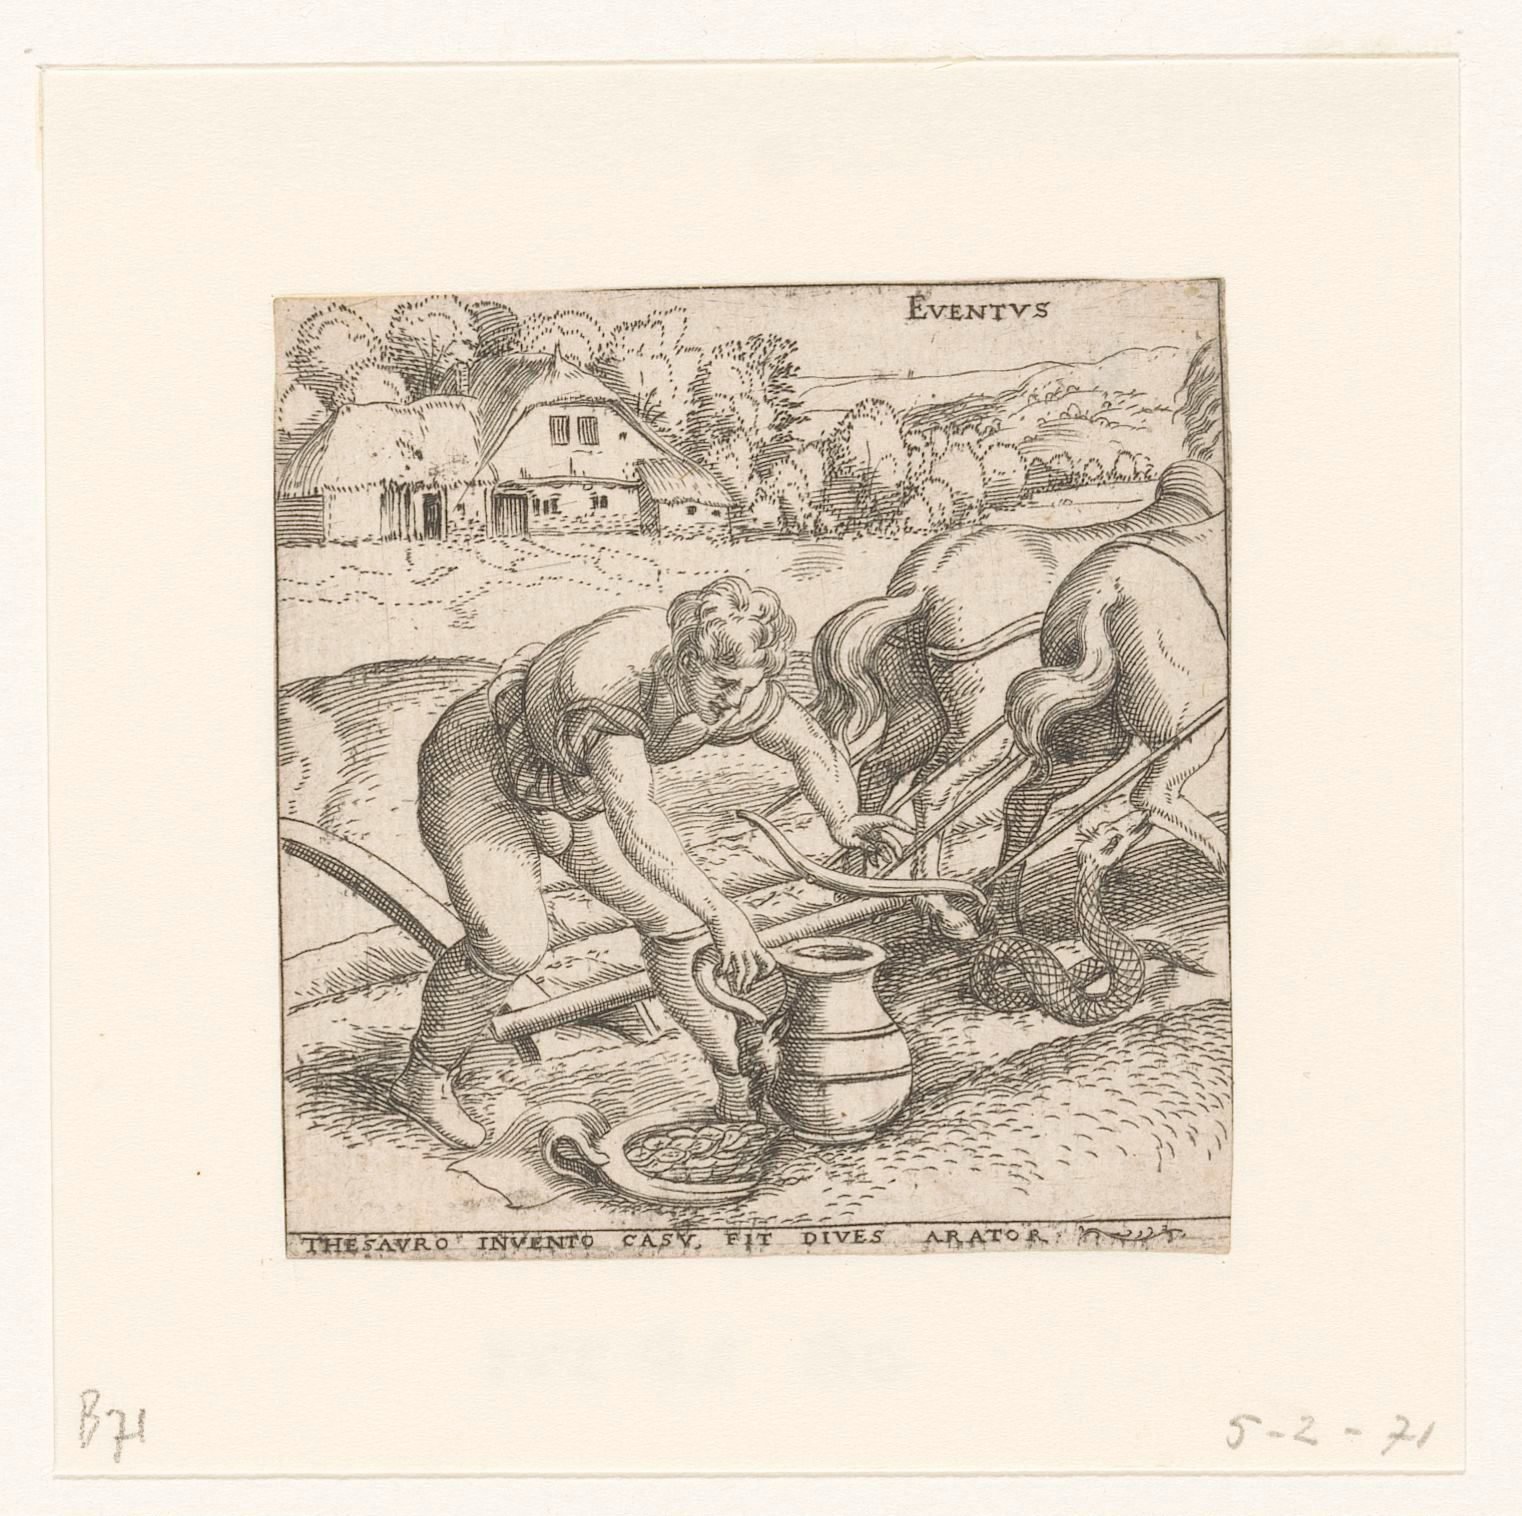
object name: print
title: Emblematische figuren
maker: francesco salviati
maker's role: draughtsman, painter, print maker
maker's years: 1510-1563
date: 1533-1567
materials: paper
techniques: engraving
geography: italy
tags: ploughing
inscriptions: collector's mark: Lugt 240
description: Tijdens het ploegen vindt een man een schaal vol met munten. Rechts twee paarden die de ploeg voorttrekken en een slang. Regel Latijnse tekst in ondermarge.